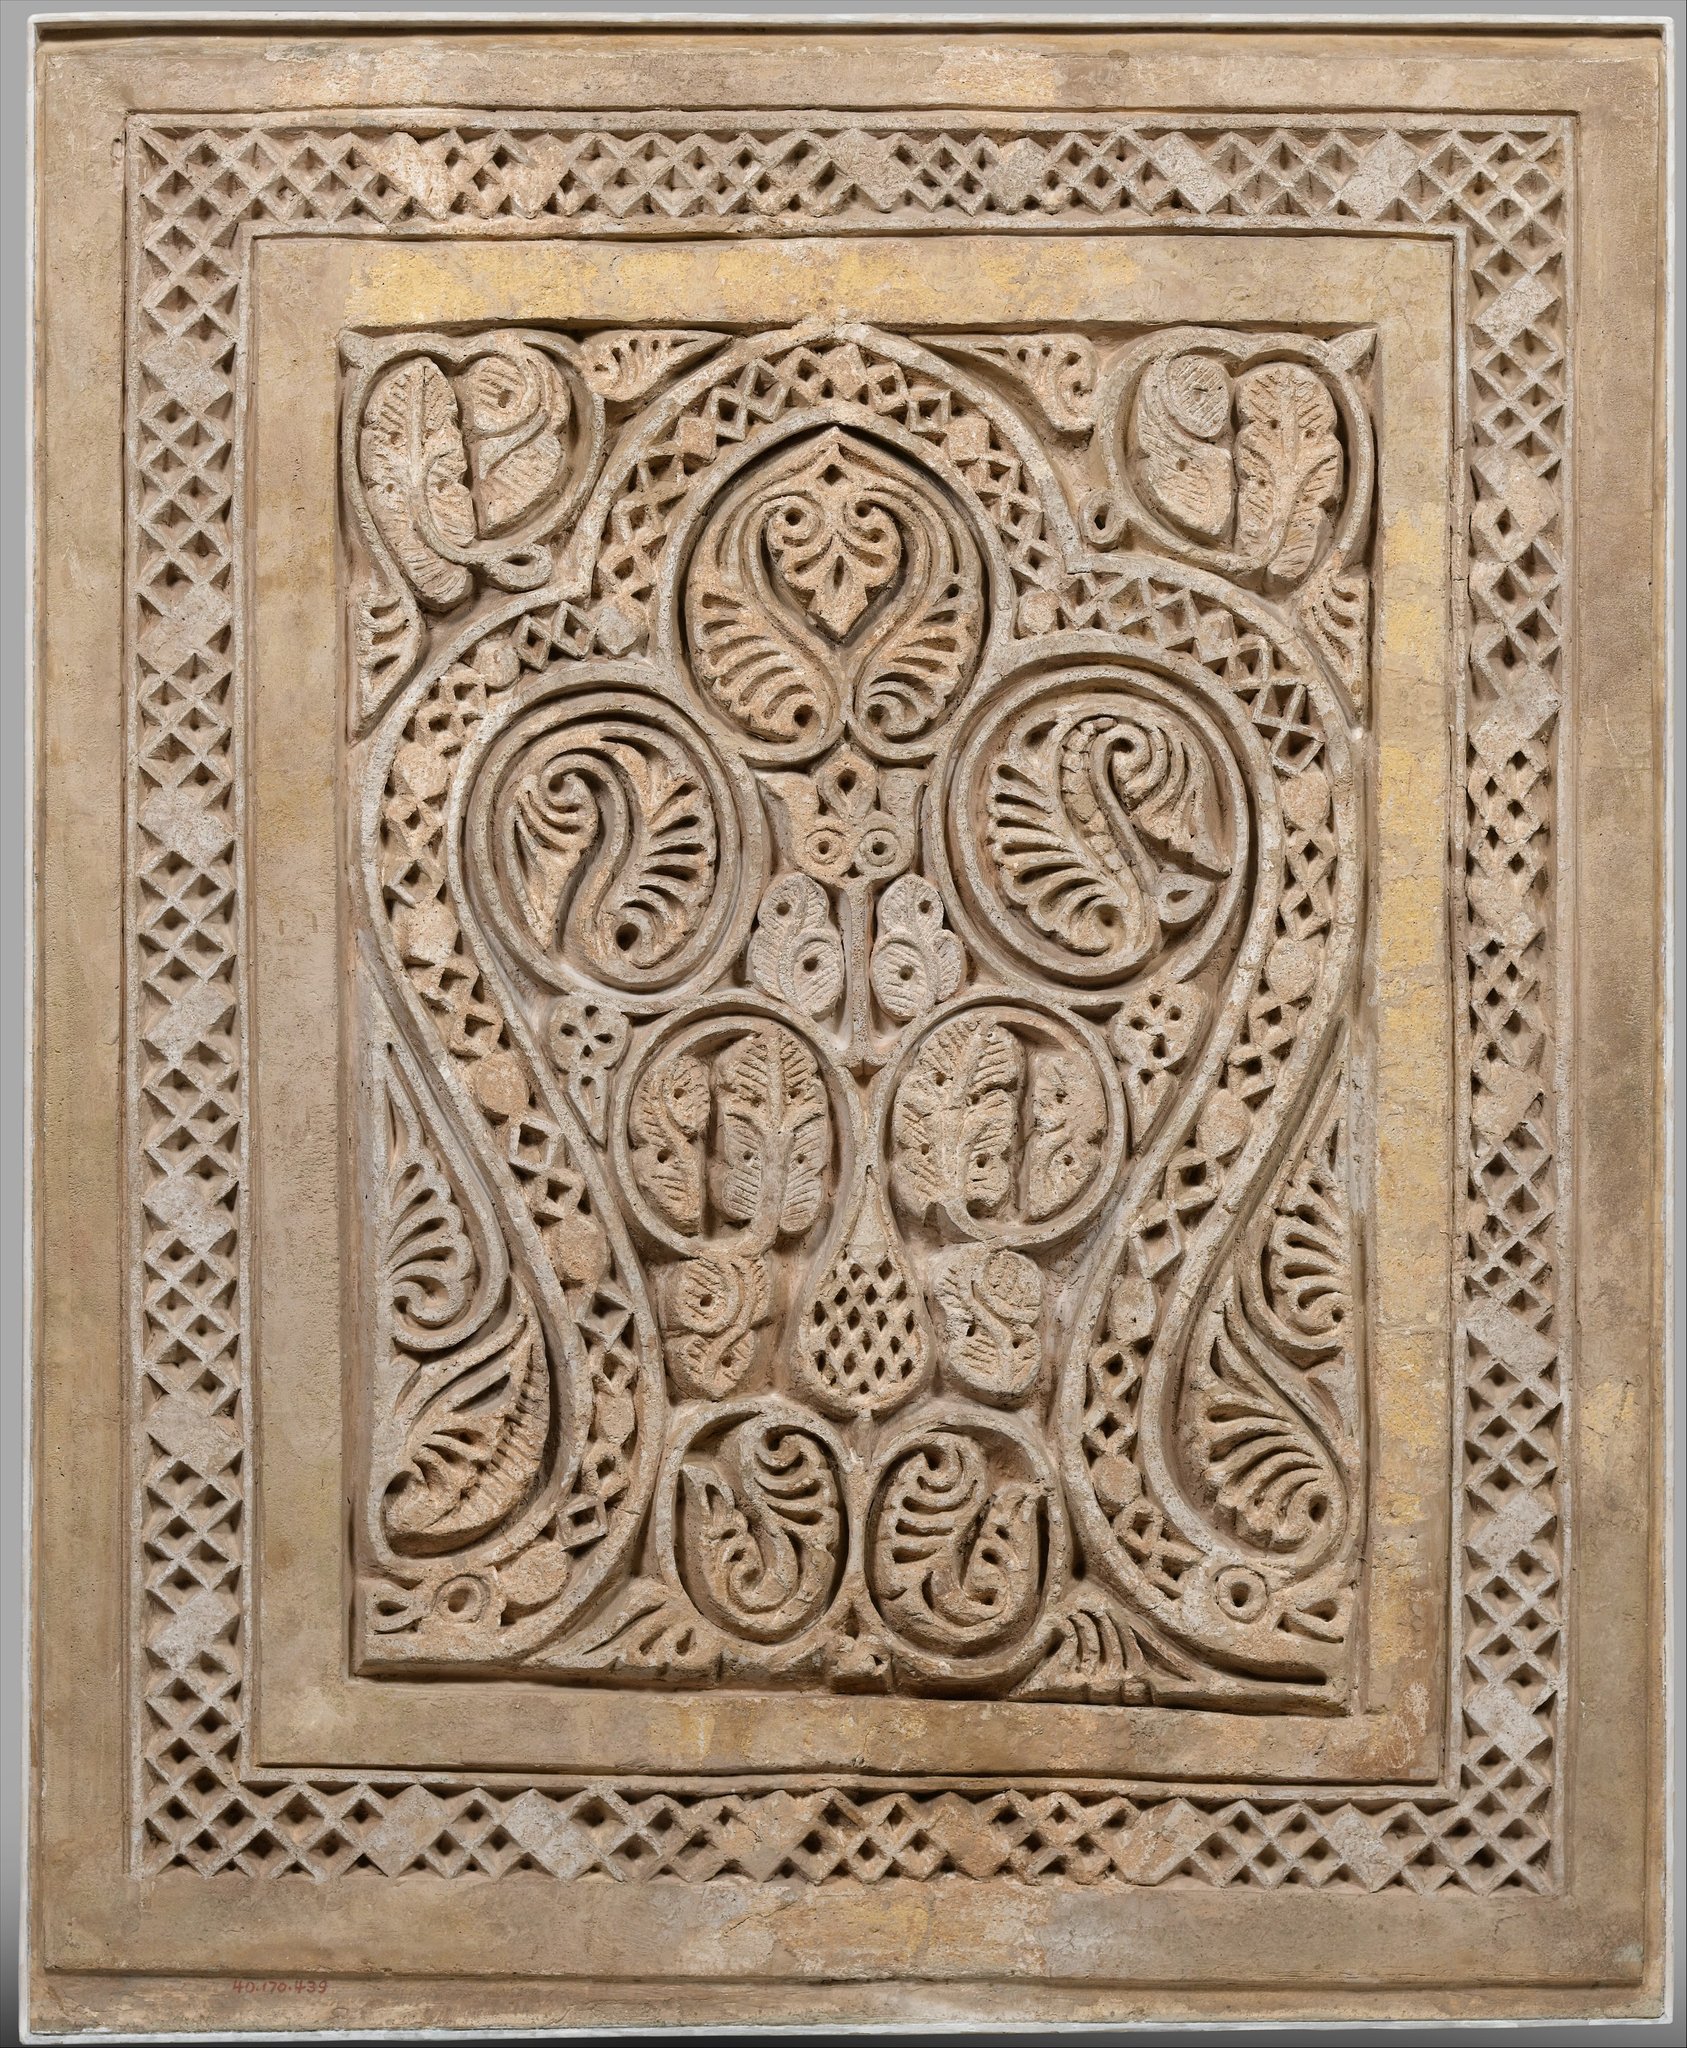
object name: dado panel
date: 901-1000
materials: plaster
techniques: carving, casting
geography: iran